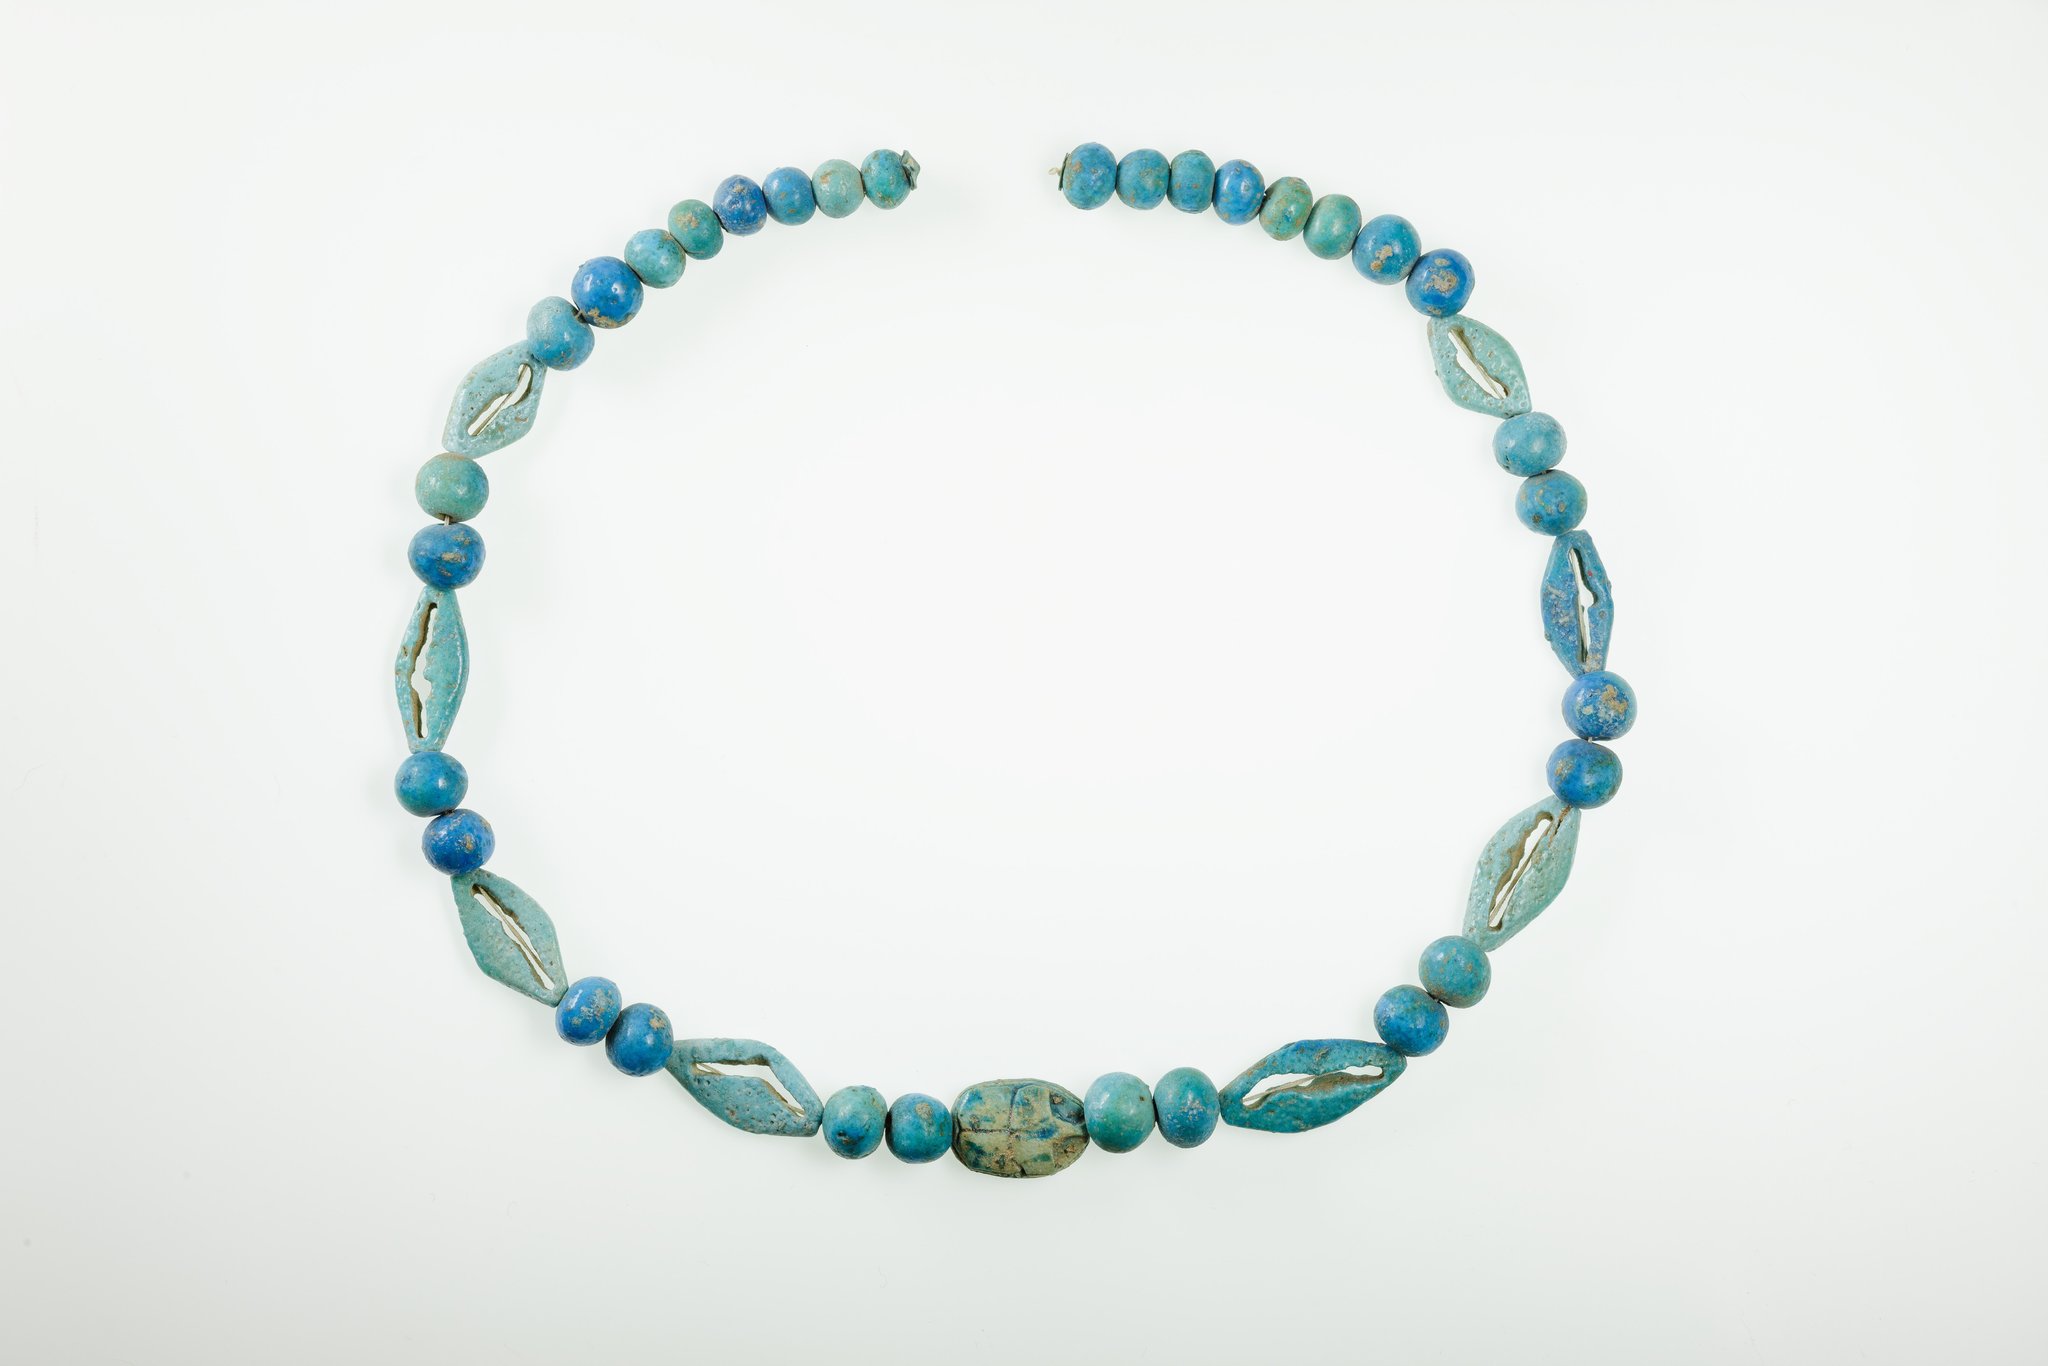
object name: bead that include a scarab, ball bead, and cowrie styled bead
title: String of ball beads, cowrie-styled beads, and a scarab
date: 1802-1450 BCE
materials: faience, stone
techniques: glazing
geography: egypt